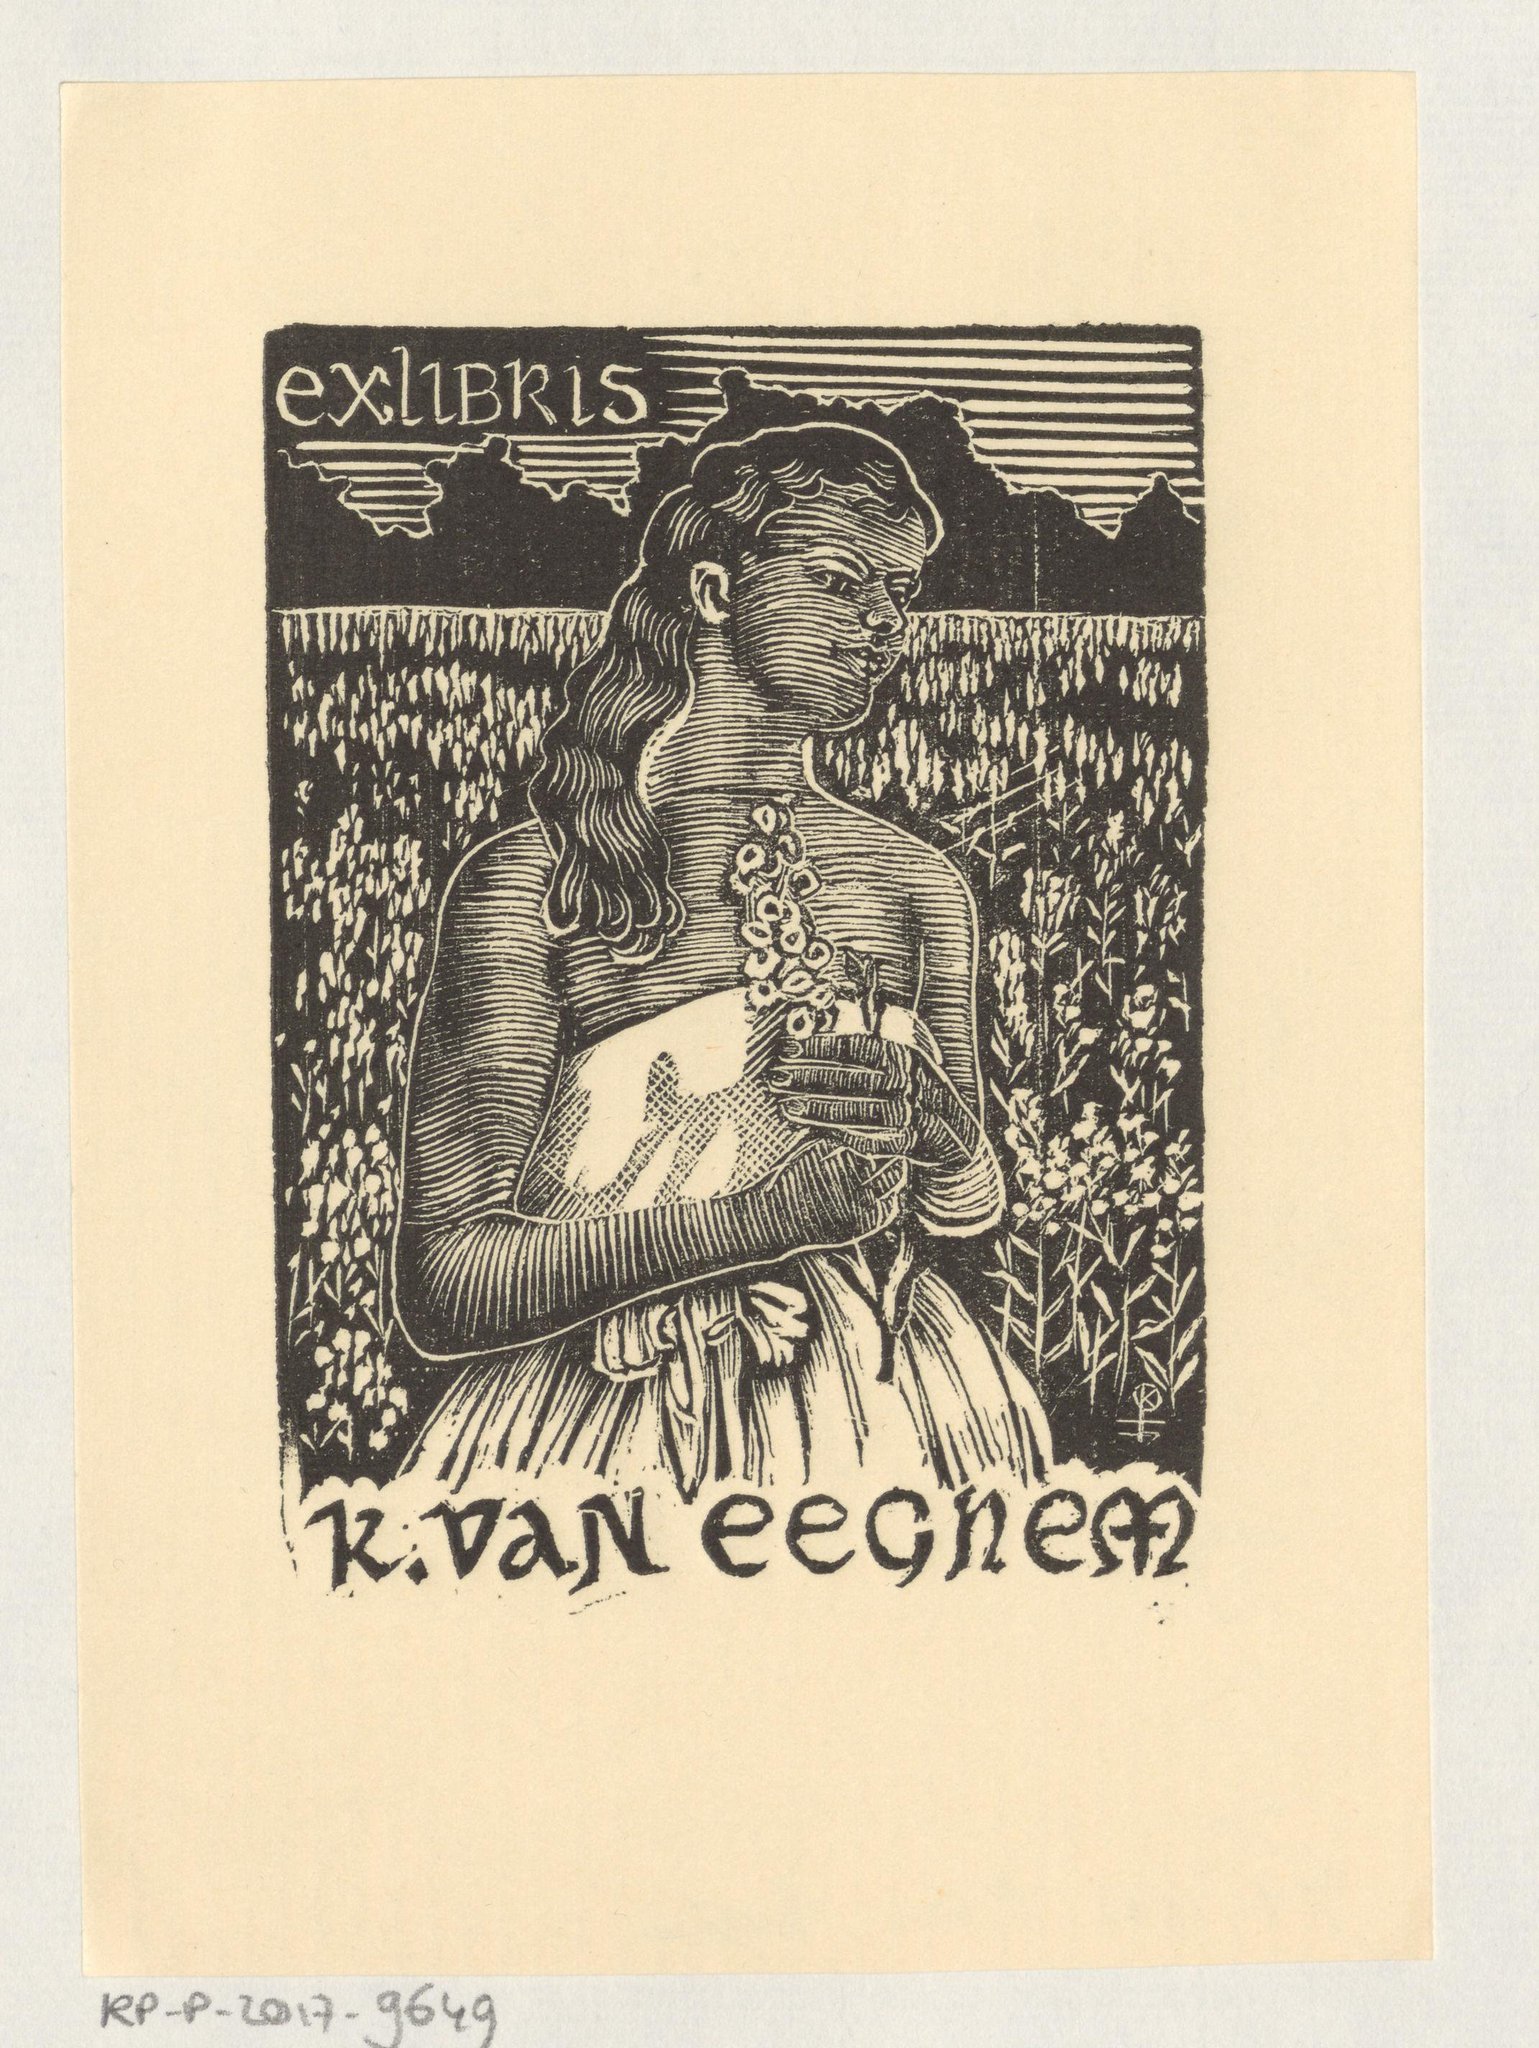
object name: bookplate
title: Ex libris van Karel van Eeghem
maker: karel van eeghem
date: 1958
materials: paper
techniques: woodcut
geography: belgium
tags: karel van eeghem, flowers, adolescent, young woman, maiden, meadow, pasture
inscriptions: inscription: ‘Xyl. 2 1958 K. van Eeghem’